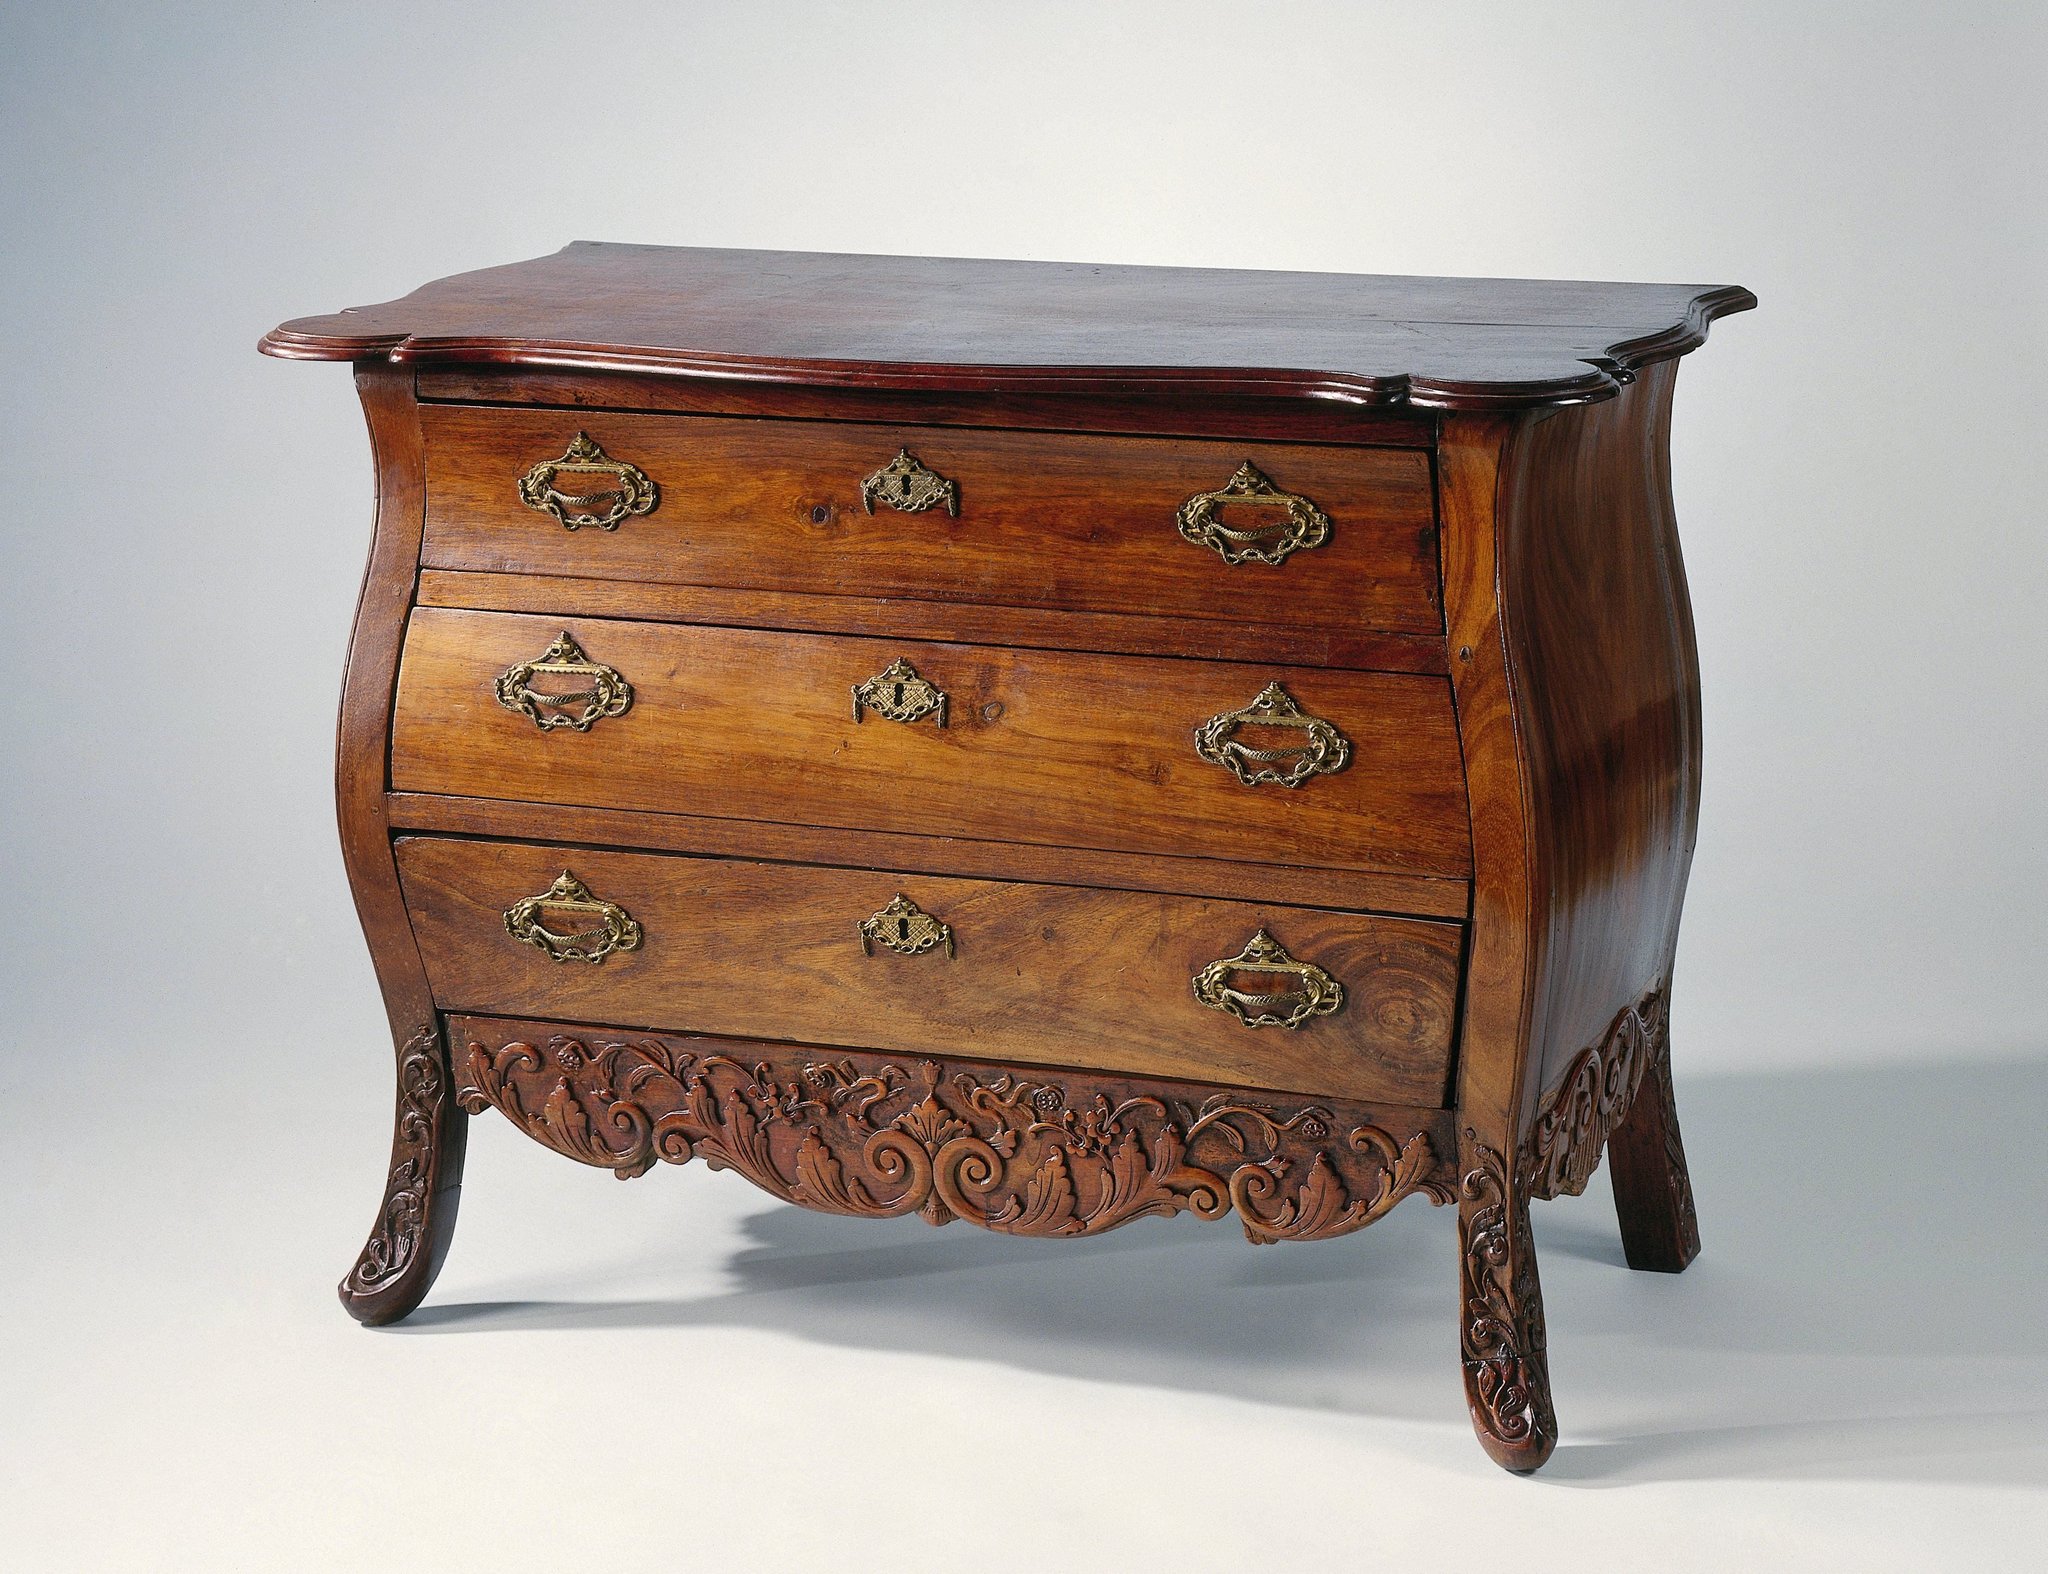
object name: commode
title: Koloniale commode met drie laden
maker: Anonymous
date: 1700-1800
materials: brass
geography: indonesia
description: Commode met drie laden. Met messing beslagen.